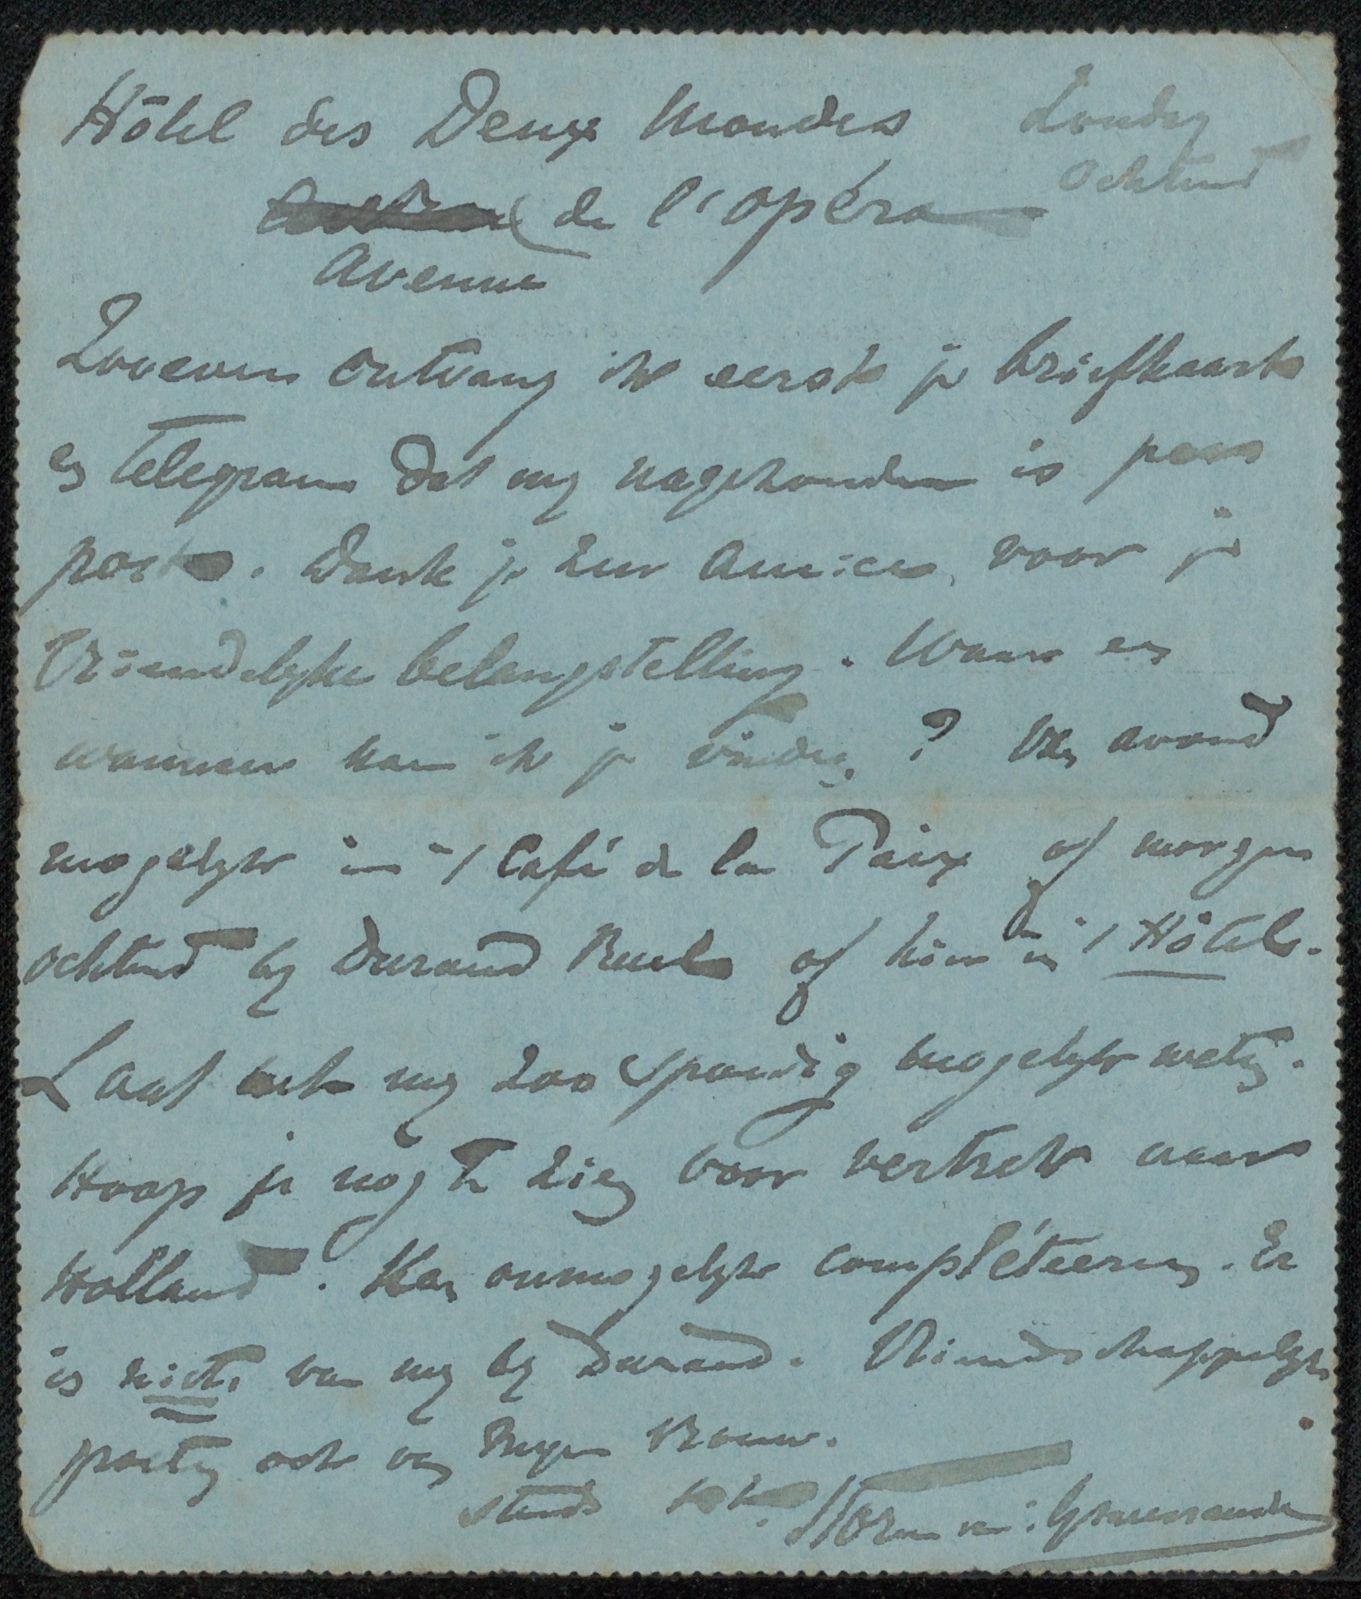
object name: postcard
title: Briefkaart aan Philip Zilcken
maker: carel nicolaas storm van s-gravesande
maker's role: draughtsman, print maker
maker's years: 1841-1924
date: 1906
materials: cardboard, ink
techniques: pen, writing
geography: paris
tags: the hague, painter, draughtsman, philip zilcken, paris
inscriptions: collector's mark: ‘RPK’